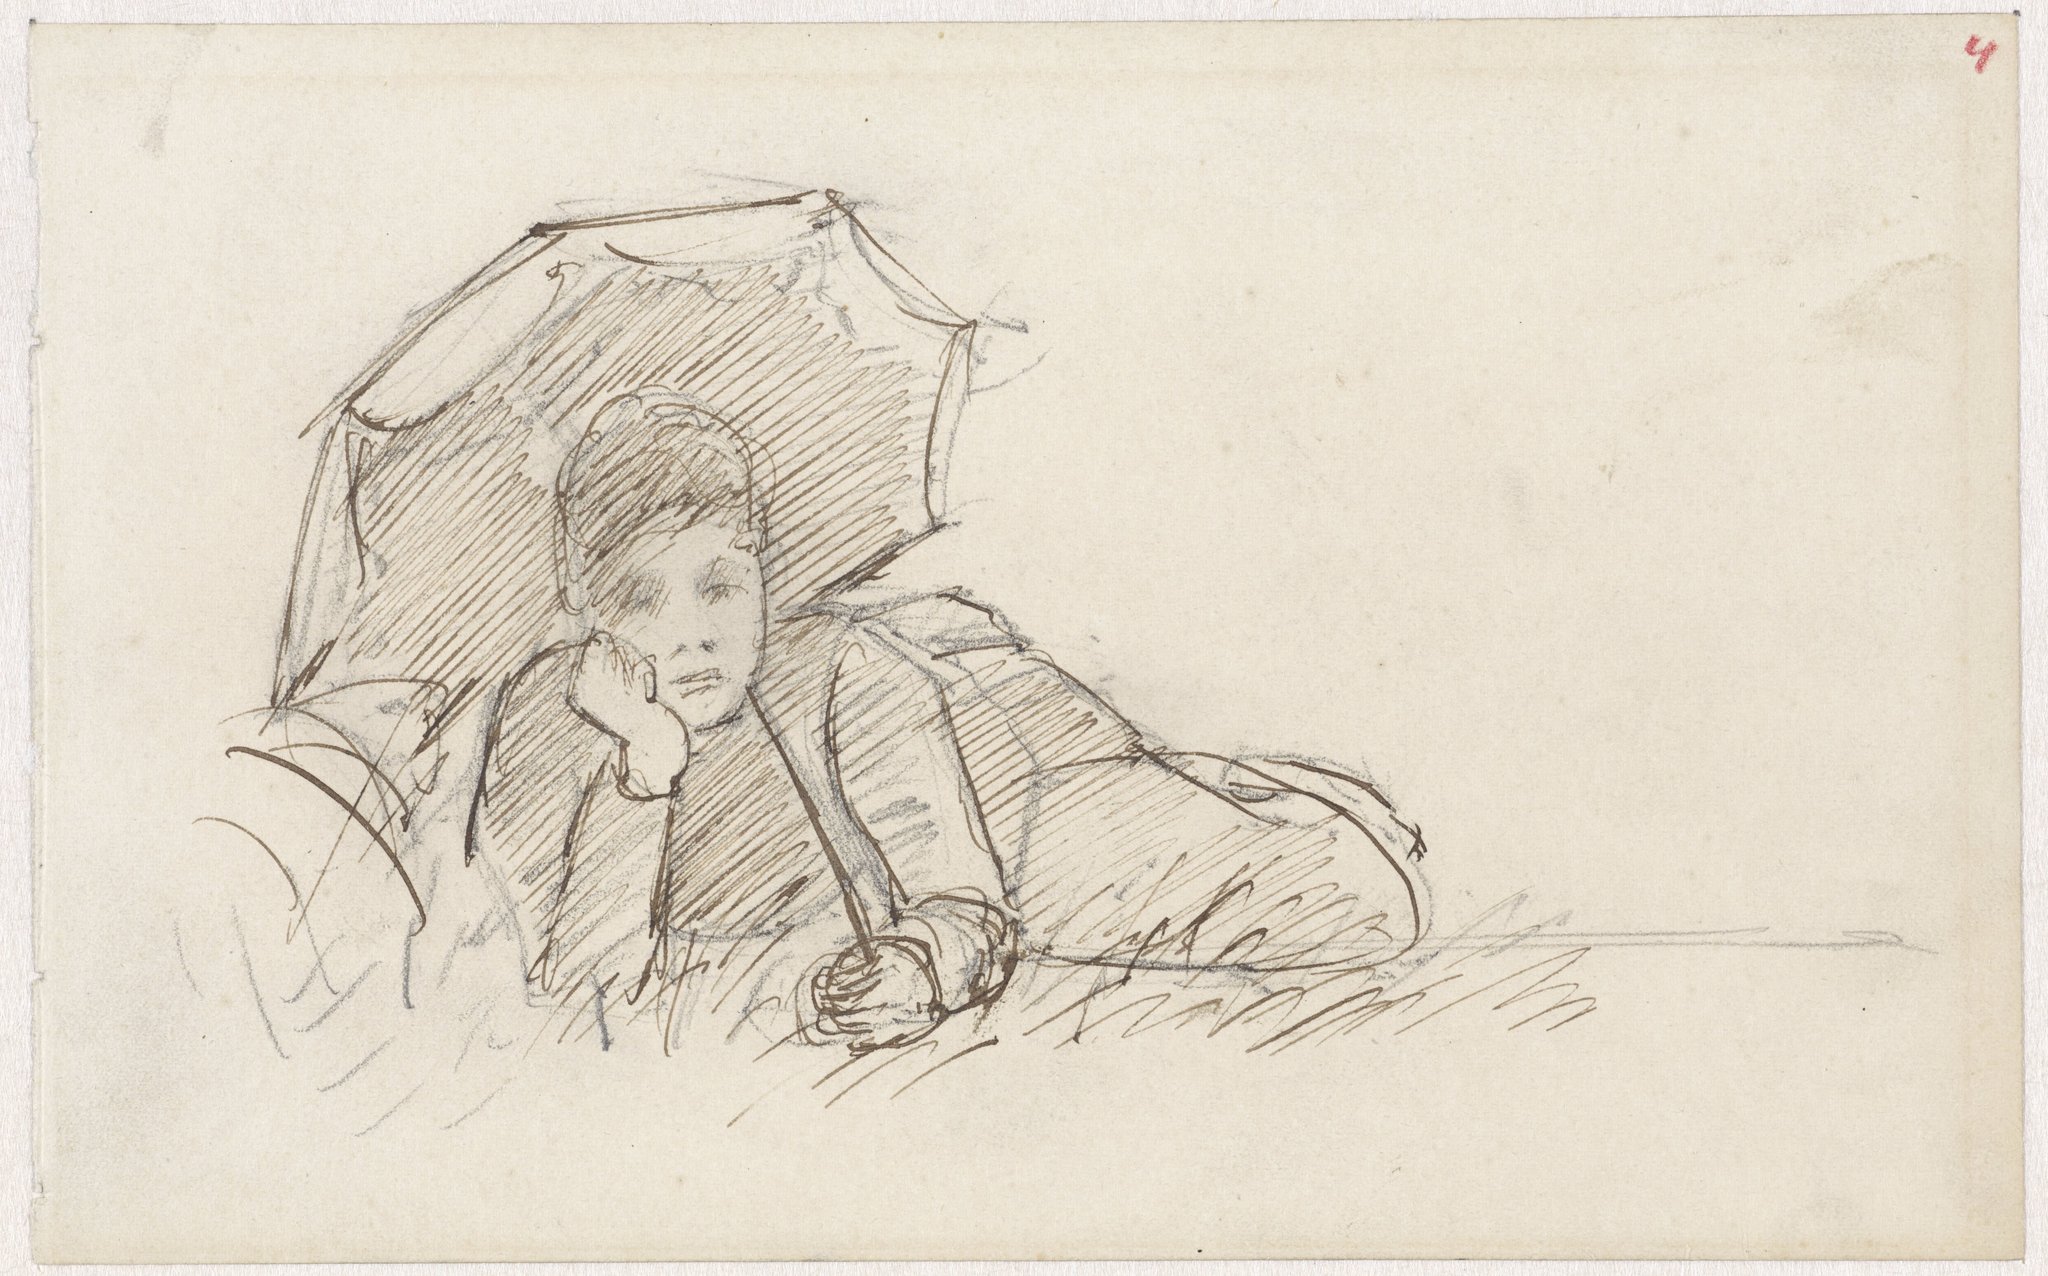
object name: drawing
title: Liggende vrouw met parasol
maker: jozef israëls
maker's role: draughtsman, painter, print maker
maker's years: 1824-1911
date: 1834-1911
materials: ink, paper, pencil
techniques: pen